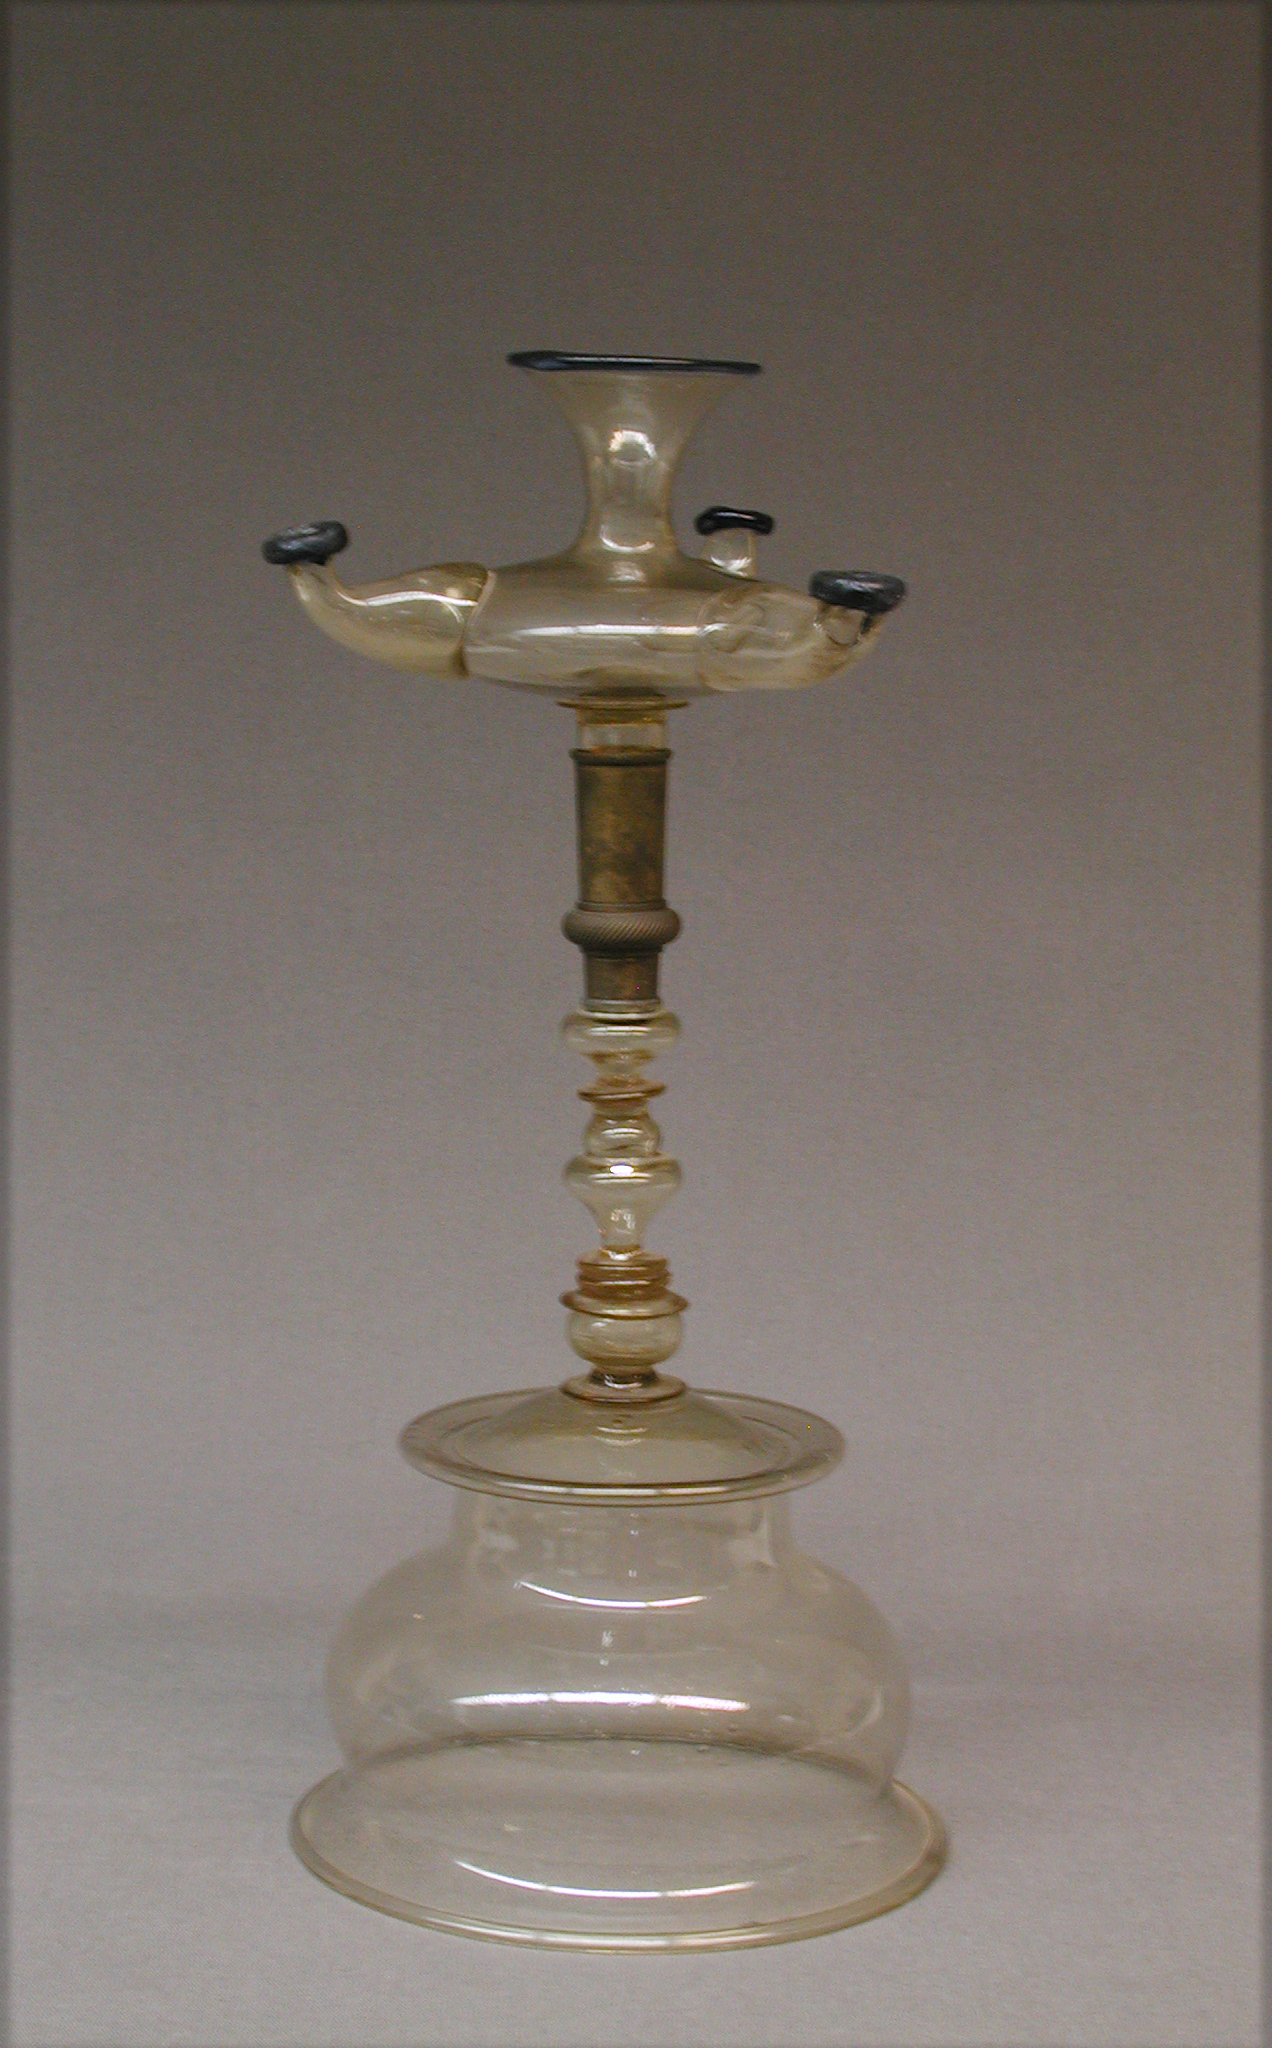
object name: lamp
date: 1701-1733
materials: glass